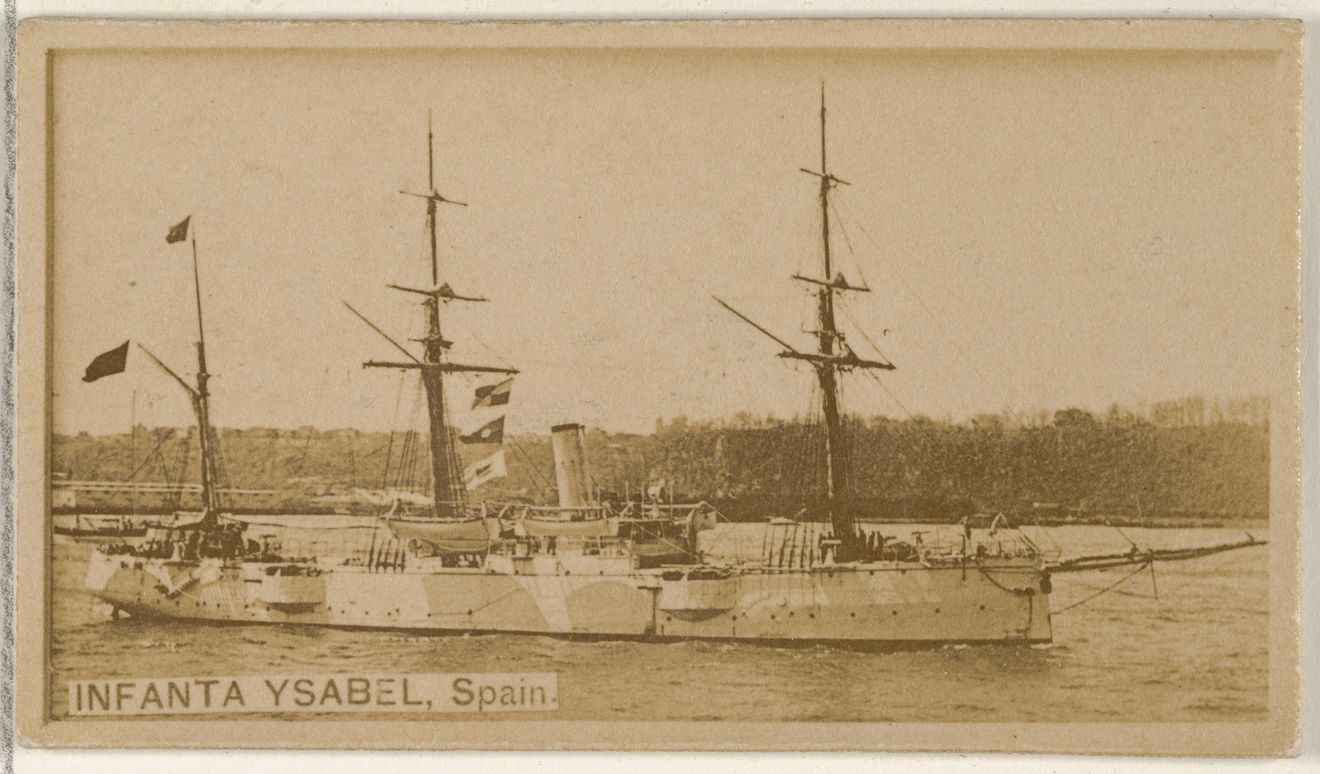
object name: photograph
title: Infanta Ysabel, Spain, from the Famous Ships series (N50) for Virginia Brights Cigarettes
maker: allen & ginter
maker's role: publisher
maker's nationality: american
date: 1895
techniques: albumen silver print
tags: ships